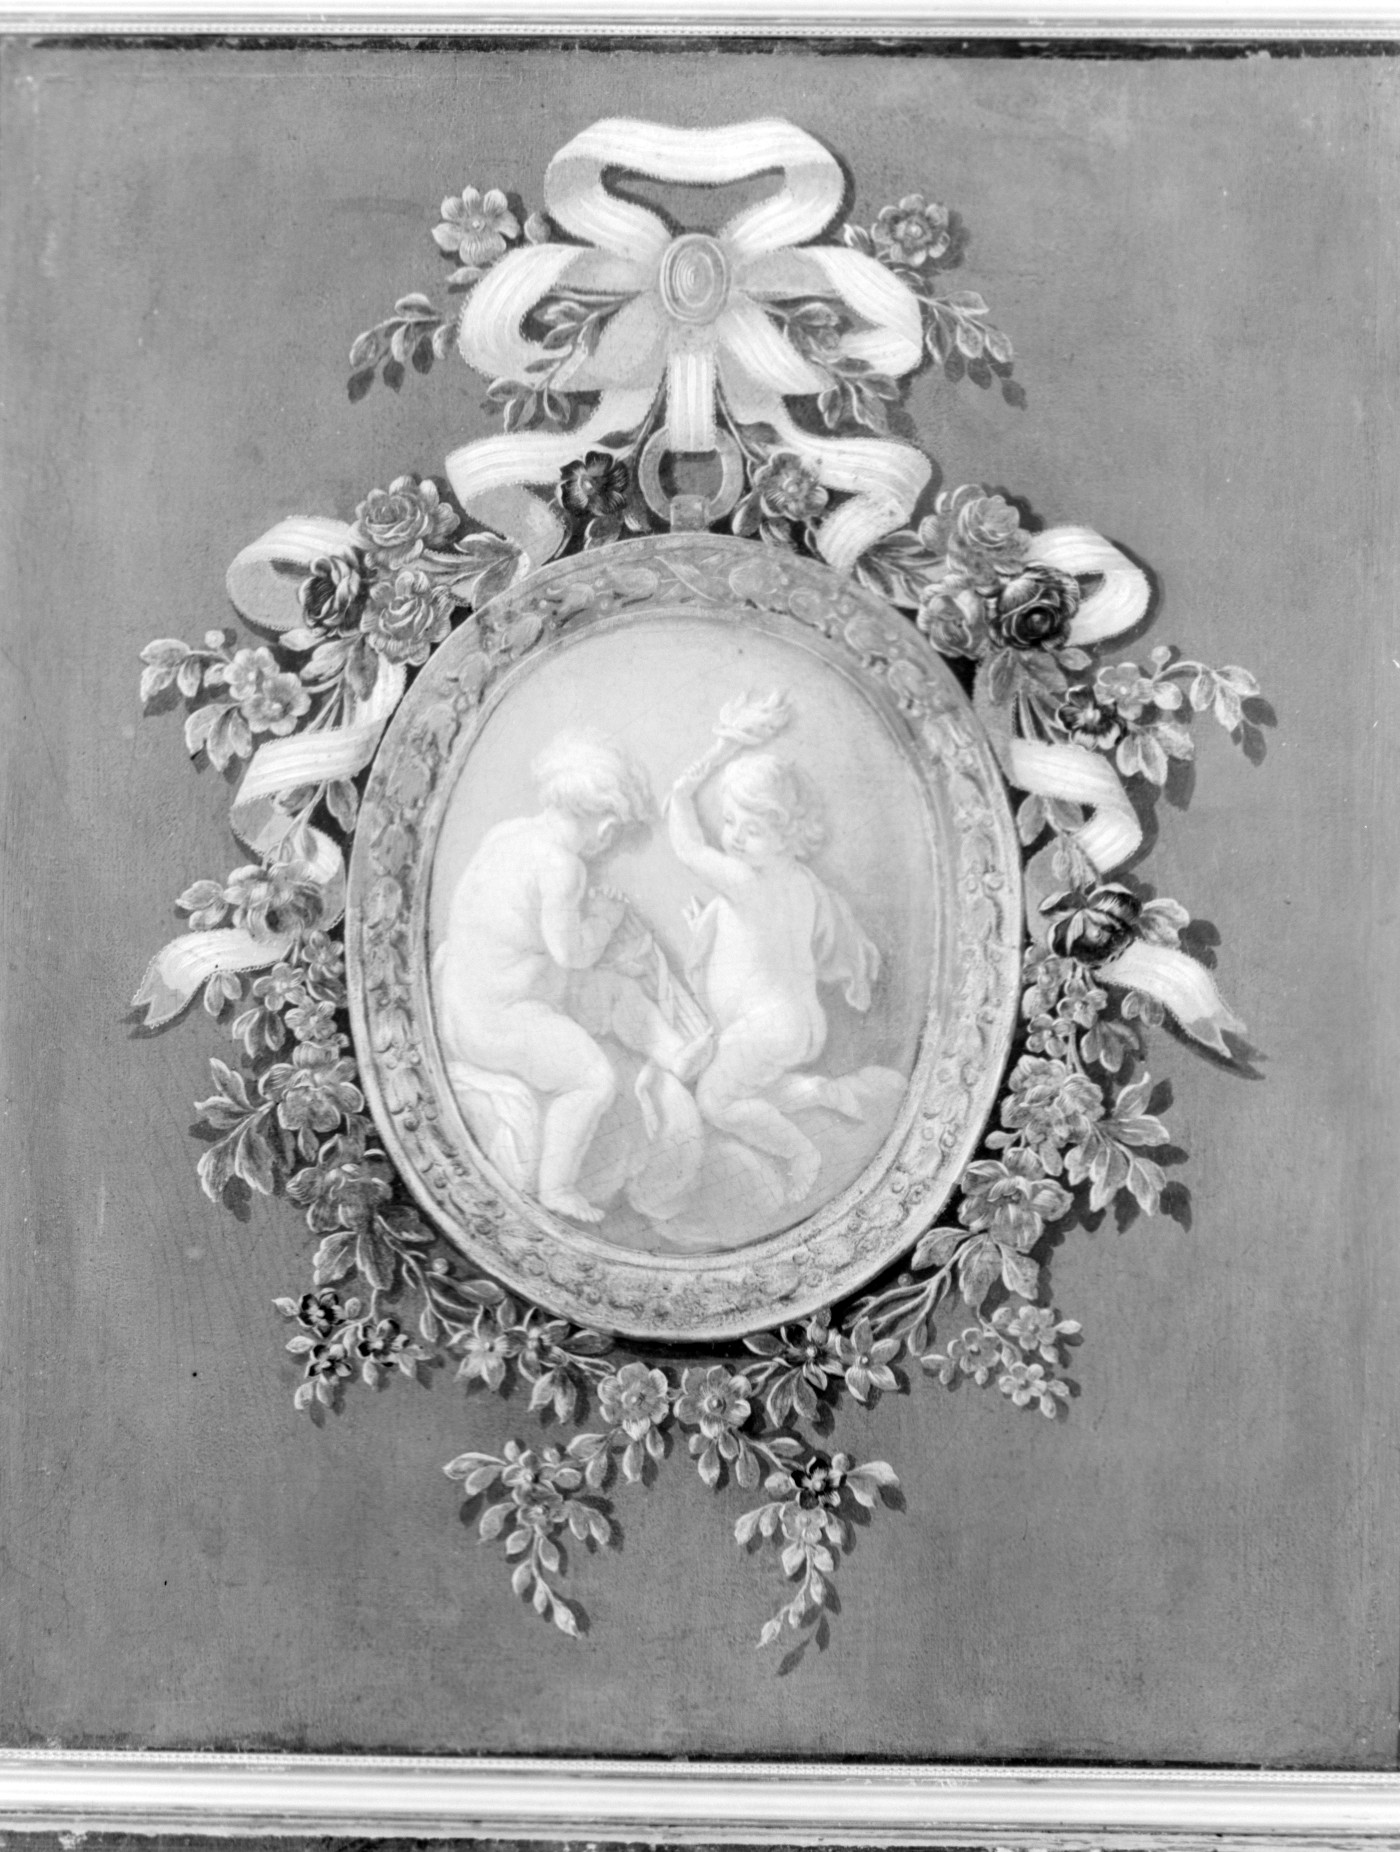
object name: overdoor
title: Putti in a Medallion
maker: french painter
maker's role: artist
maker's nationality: french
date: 1701-1800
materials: canvas, oil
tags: garlands,putti,flowers